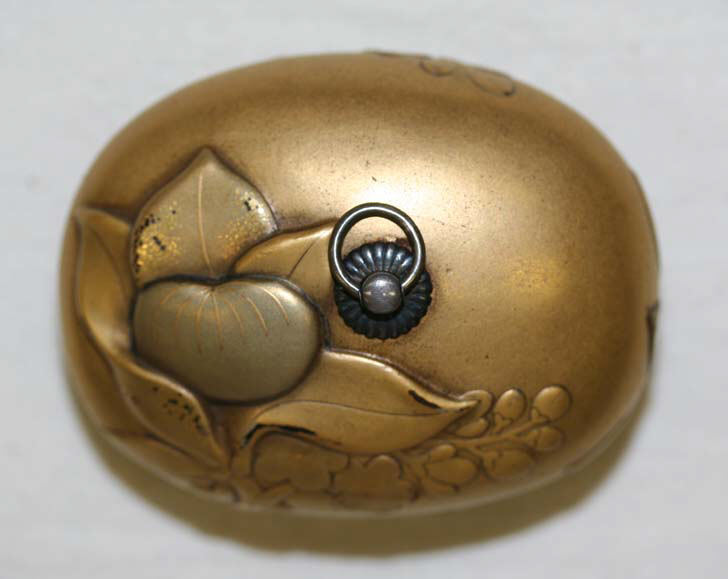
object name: ornament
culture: japanese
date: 1867-1900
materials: metal, wood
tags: flowers,leaves